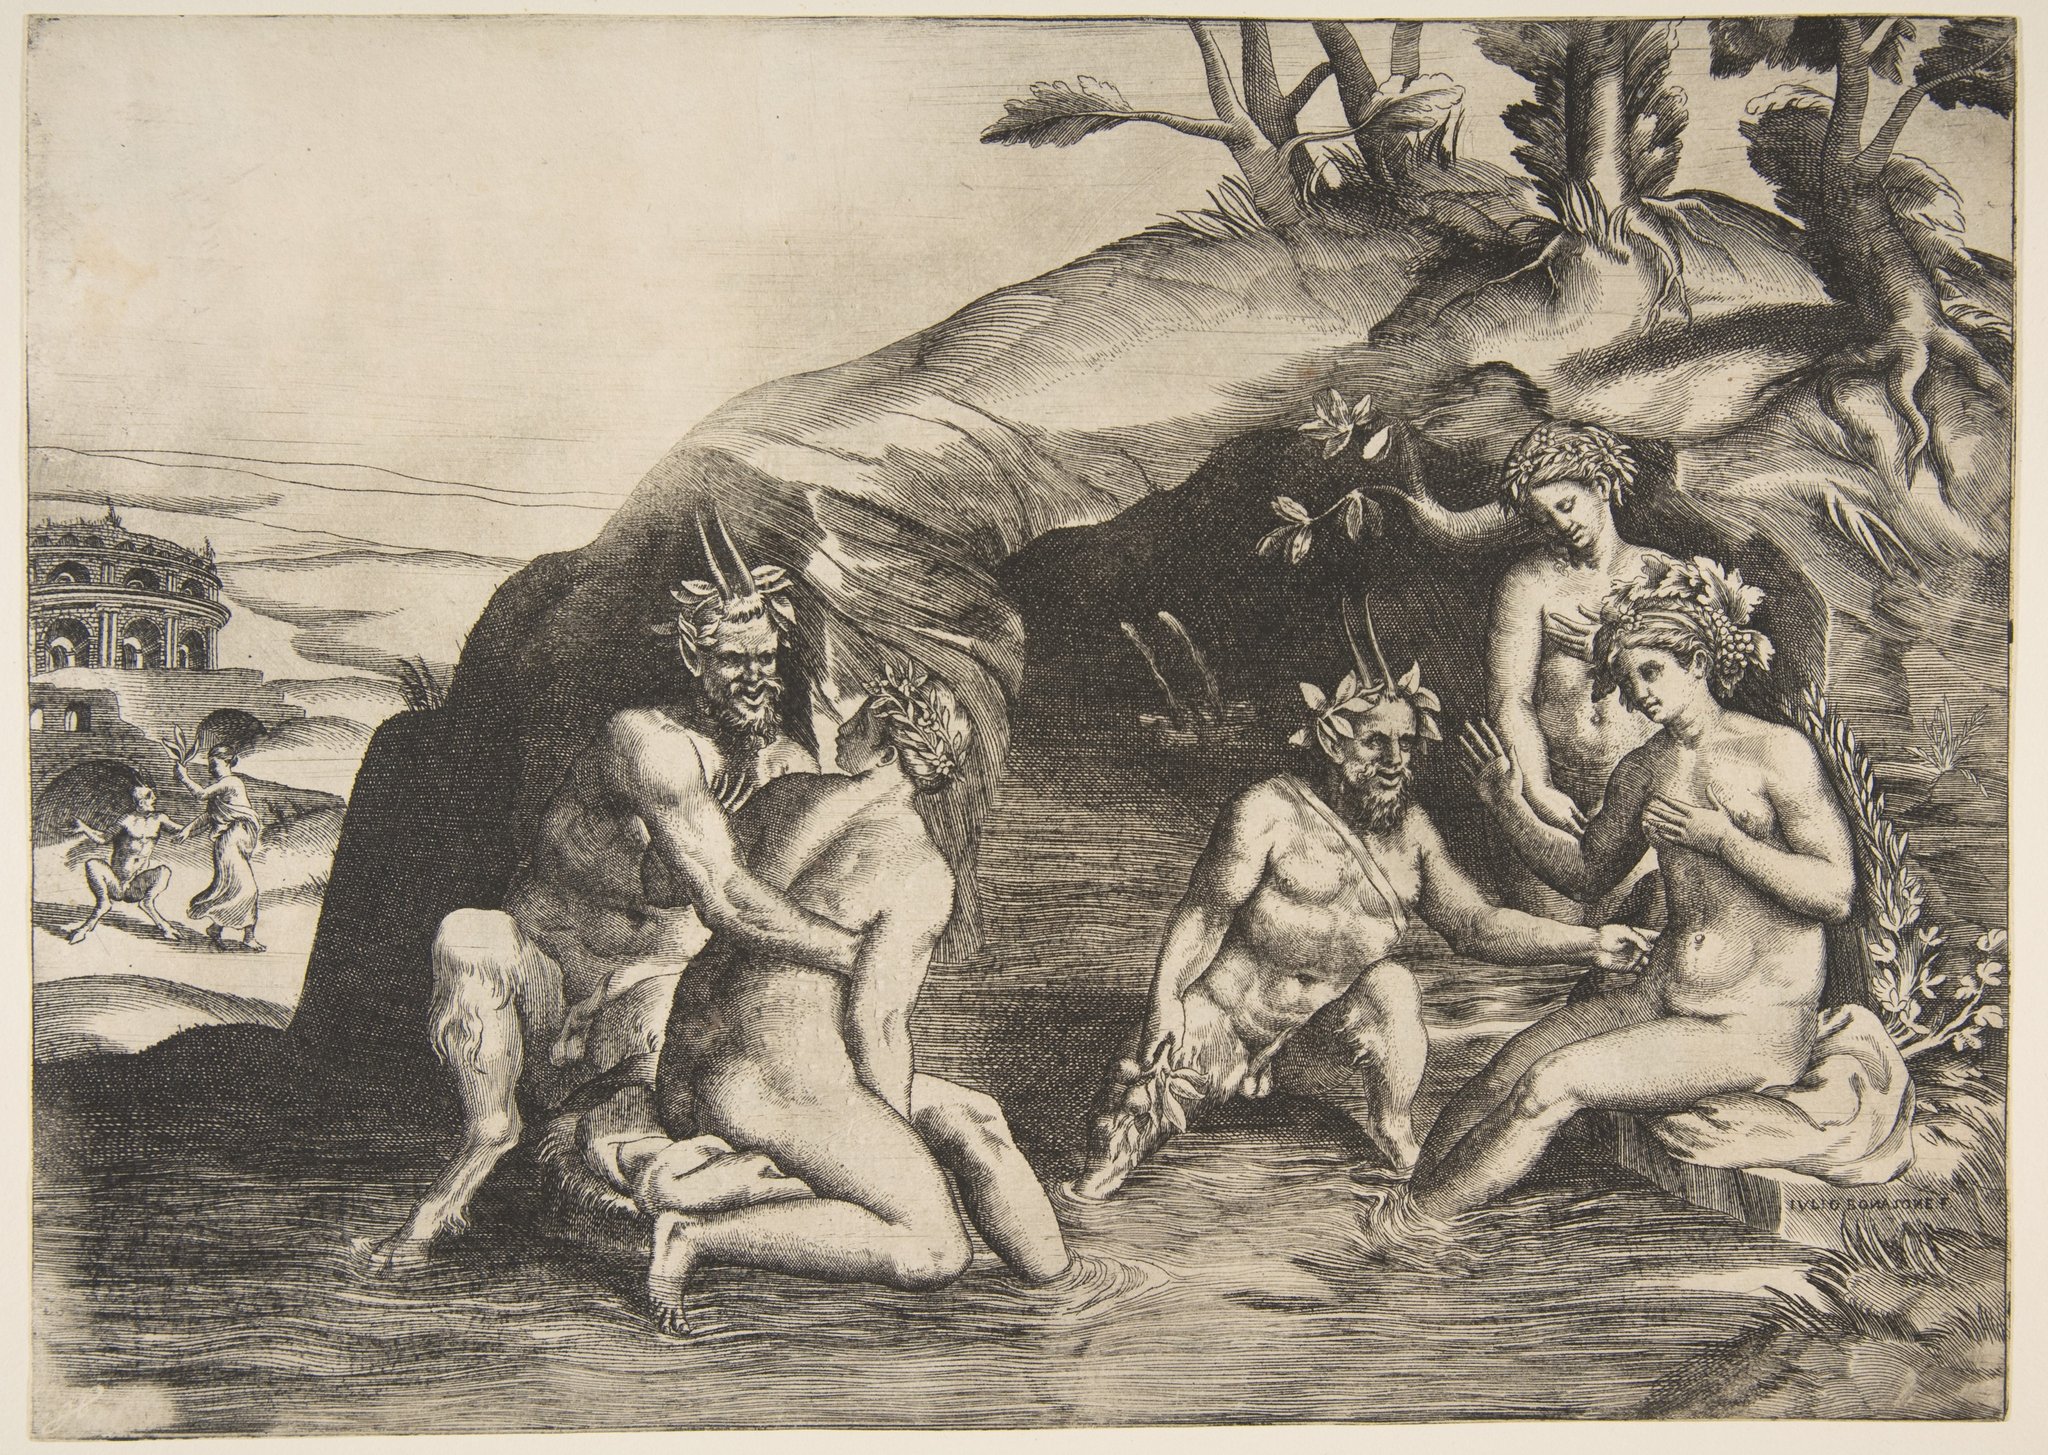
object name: print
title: Nymphs and Satyrs bathing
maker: giulio bonasone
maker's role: artist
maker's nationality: italian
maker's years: 1510-1576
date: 1531-1576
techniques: engraving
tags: nymphs,satyrs,bathing